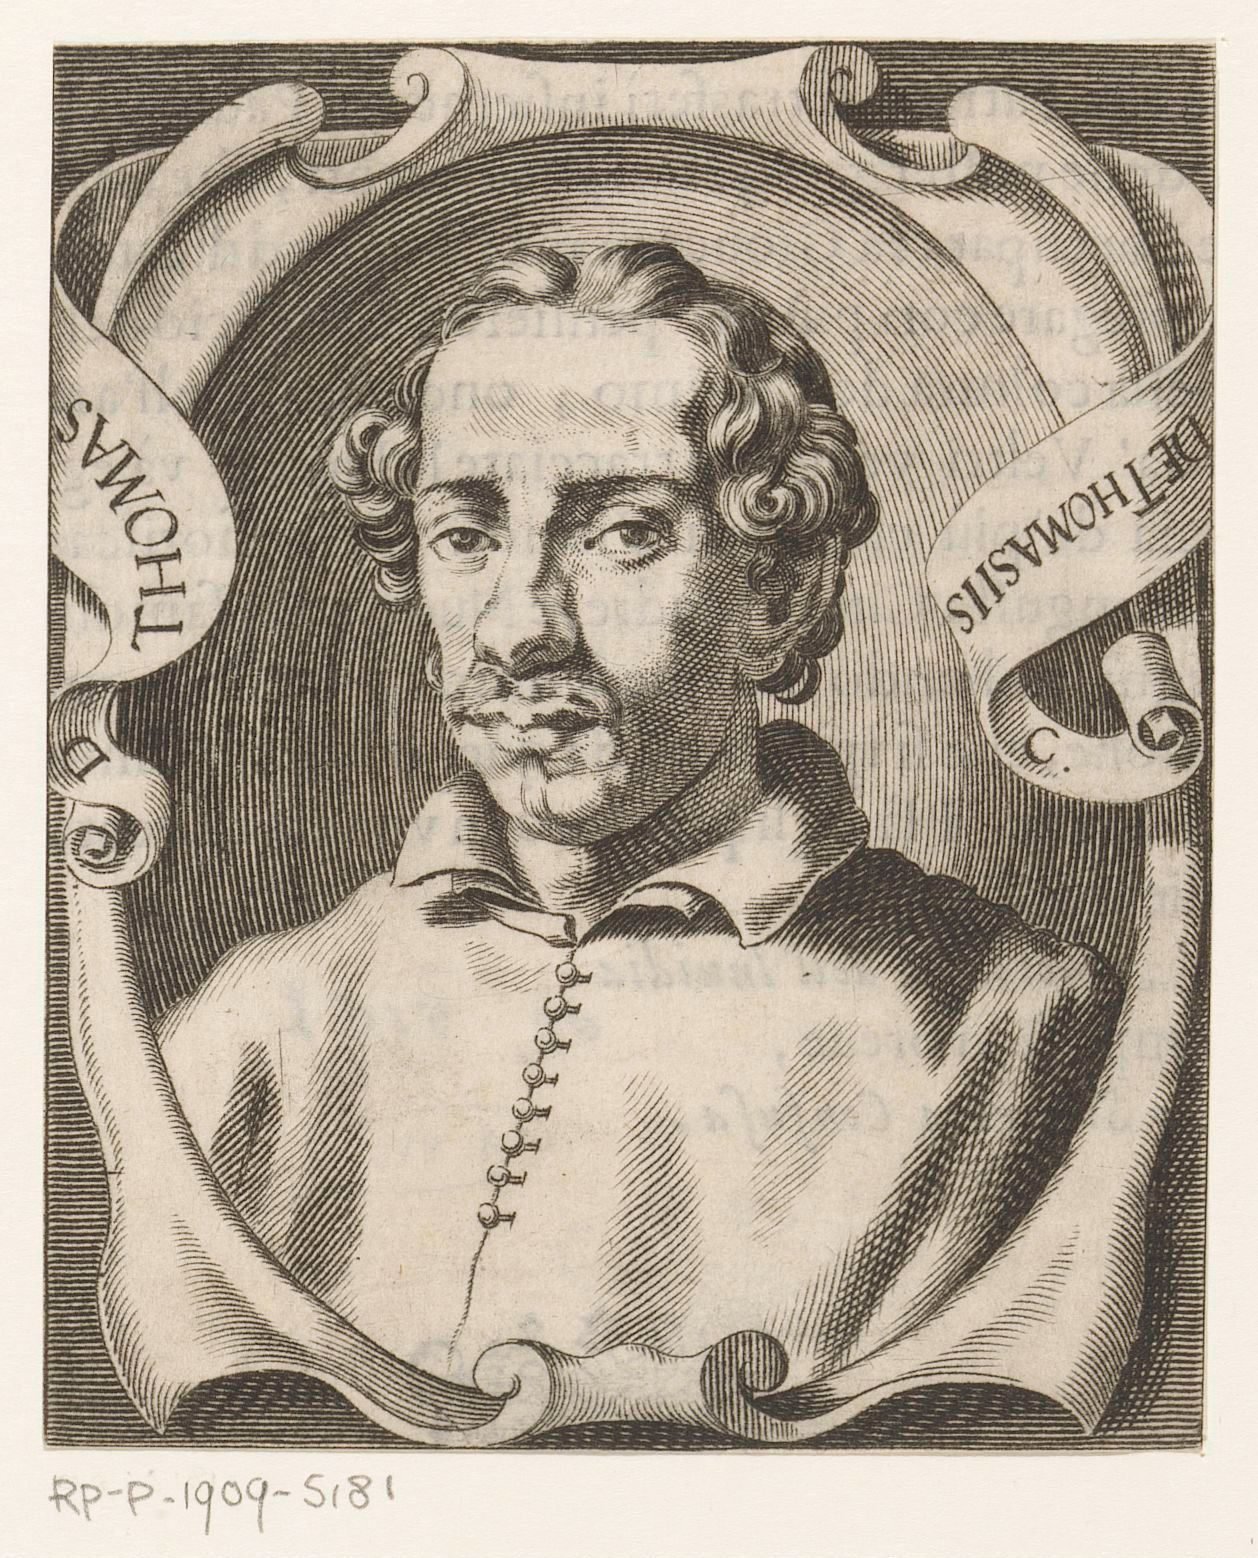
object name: book illustration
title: Portret van filosoof Tomaso Tomasi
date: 1647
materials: paper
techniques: engraving, letterpress printing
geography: venice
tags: historical persons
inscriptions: collector's mark: Lugt 2228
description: Prent uit de publicatie: Loredan, Giovan Francesco. Le glorie degli Incogniti. Venetië: Francesco Valvasense, 1647, p. 416.